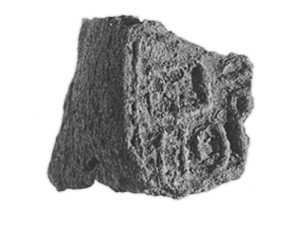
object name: sealing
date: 2030-1640 BCE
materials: clay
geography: egypt